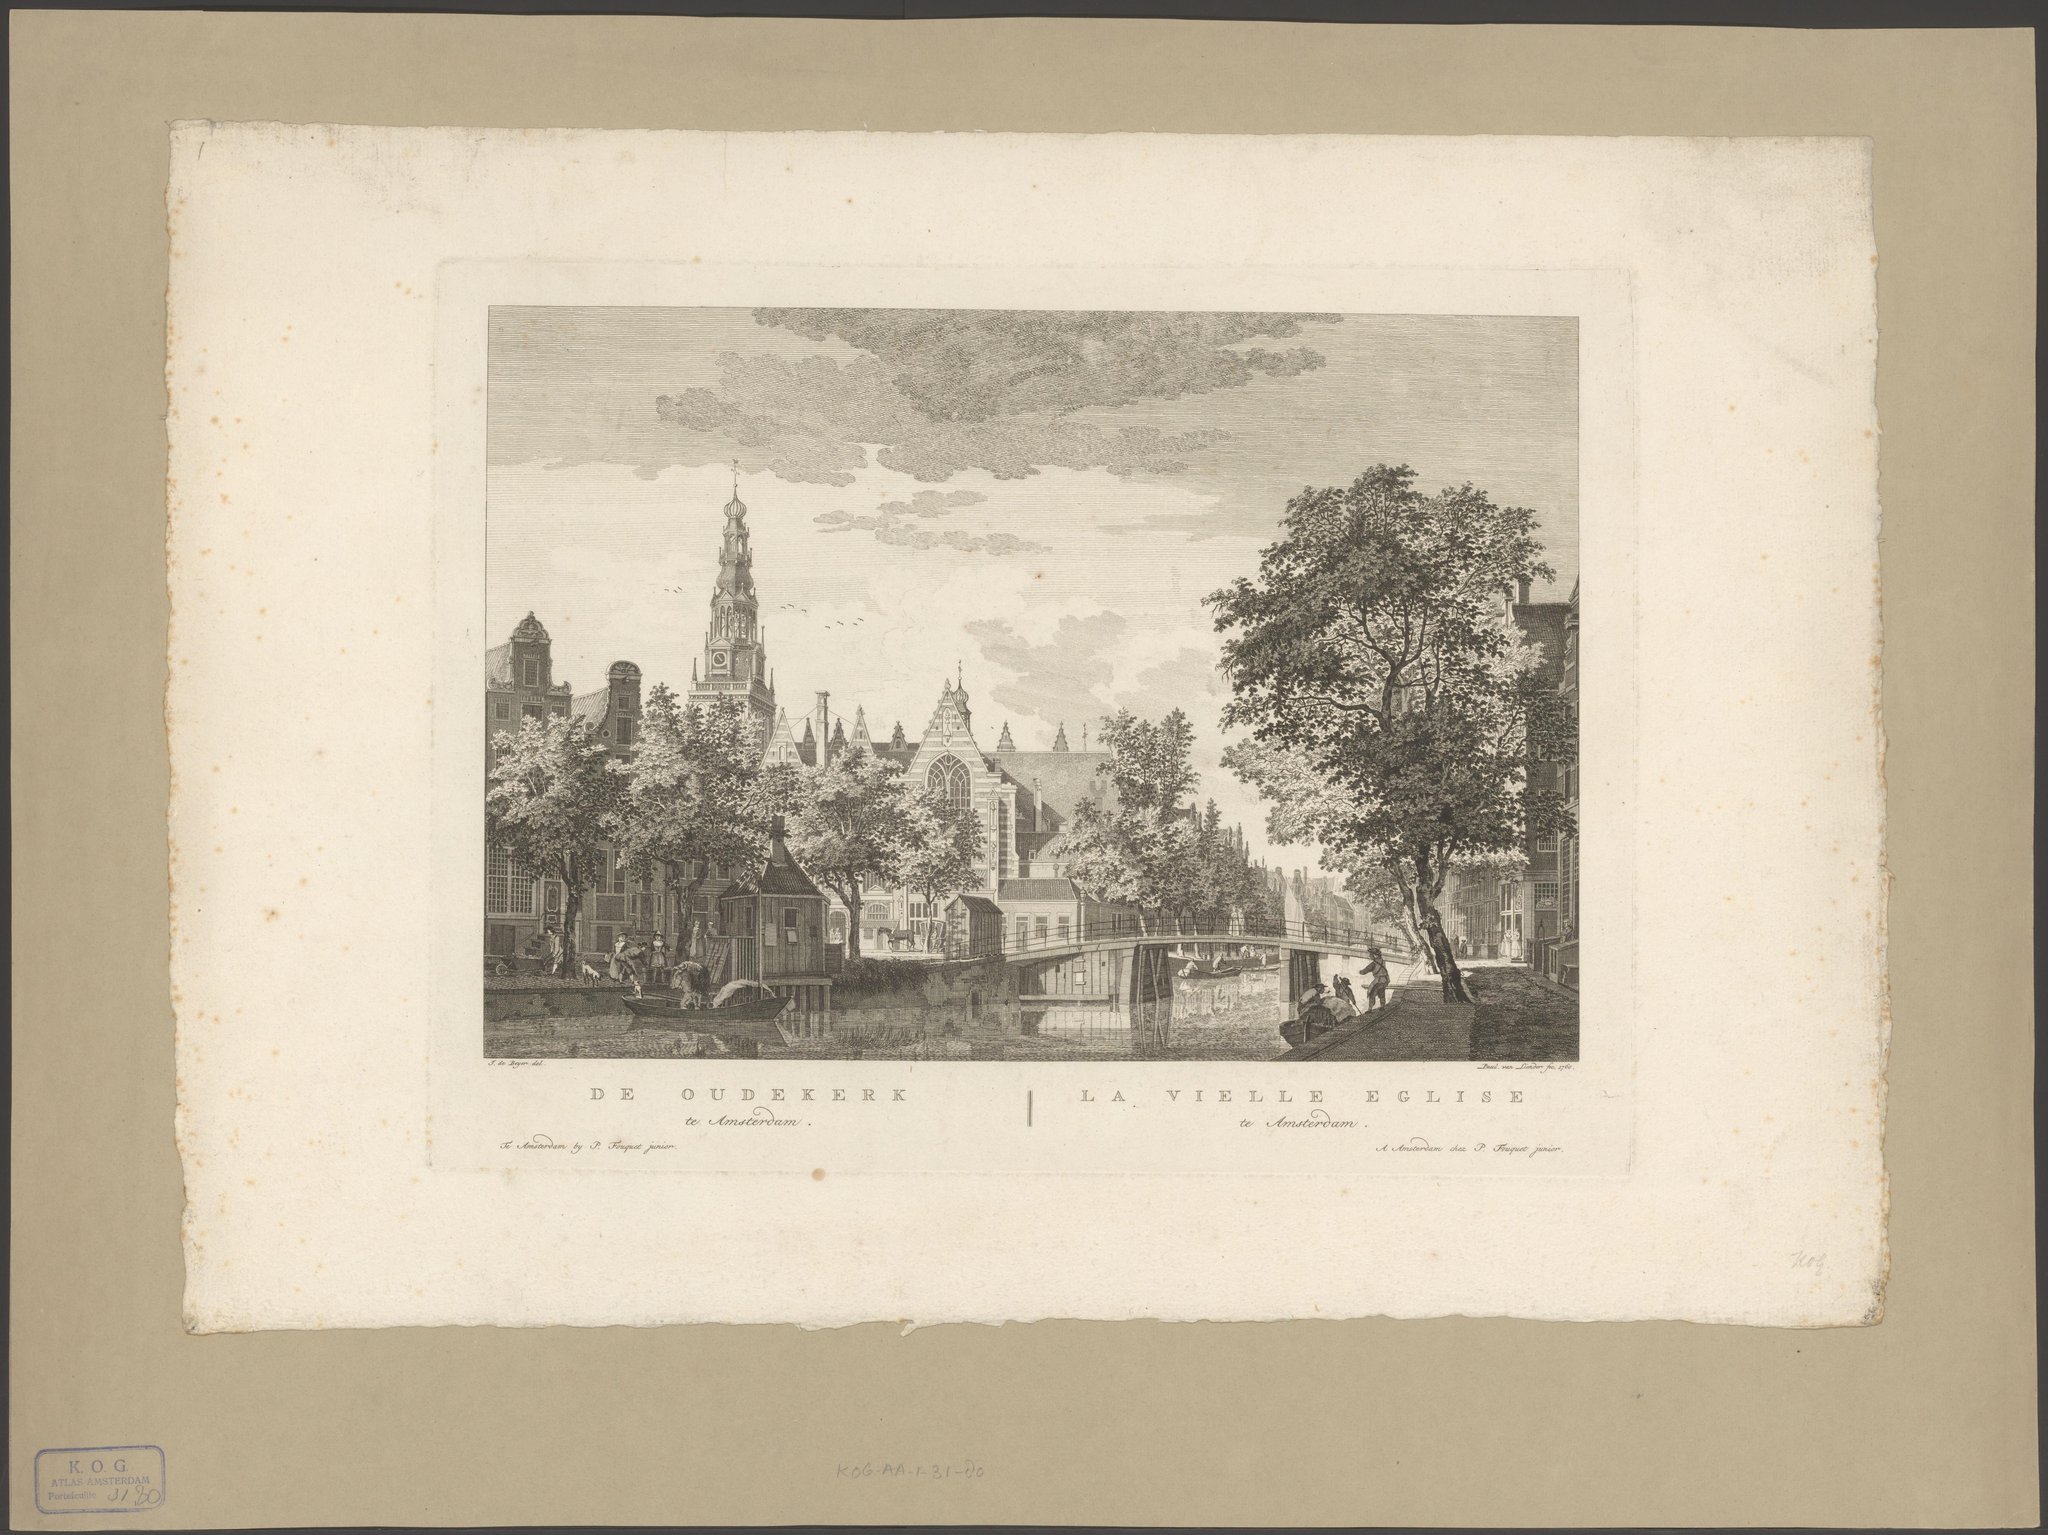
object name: print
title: Gezicht op de Oude Kerk te Amsterdam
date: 1760-1783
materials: paper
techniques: engraving, etching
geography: northern netherlands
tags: bridge in city across river, canal, etc. (+ city(-scape) with figures, staffage), church (exterior)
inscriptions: collector's mark: ‘31.80’ Lugt 1641b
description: Deze prent is ook gebruikt in de zogenaamde Atlas van Fouquet.* Pierre Fouquet gaf vanaf 1760 stadsgezichten van Amsterdam - naar tekeningen van verschillende kunstenaars, gemaakt door verschillende prentmakers - uit. Deze prenten werden aanvankelijk los of in series verkocht. Zoals toen gebruikelijk kon de koper de prenten zelf laten inbinden. Hiertoe gaf Fouquet tussen 1778 en 1783 een titelblad, plattegrond en inhoudsopgave van de tot dusver 100 uitgegeven prenten uit (1). Gezien de inhoud afhankelijk was van wat de koper had verzameld verschilt de inhoud van de verschillende bewaarde Fouquetatlassen onder deze titel sterk. Ook zijn er exemplaren bekend waar tevens andere prenten aan zijn toegevoegd. Omdat er behoefte bleek aan uitleg bij de platen werd in 1783 een nieuwe versie van de atlas uitgegeven, aangevuld met tekst en twee prenten. De aangegeven volgorde veranderde maar de platen van de al eerder uitgegeven prenten bleven ongewijzigd. Deze uitgave werd in opdracht van Fouquet gedrukt bij Daniël Jean Changuion en Petrus den Hengst (2). Een tiental platen werd bijgewerkt en verscheen, met nieuw impressum, in het vervolg van Wagenaars geschiedenis van Amsterdam, uitgeven door Petrus Conradi en Folkert van der Plaats (3). Een aantal jaar na het overlijden van Fouquet kwam Evert Maaskamp met een nieuwe uitgave van de atlas, met verbeterde tekst en toevoeging van twee prenten. Op alle platen verwijderde hij het oude en liet hij zijn eigen impressum zetten (4). De huidige staat van de prent komt voor in exemplaren van de onder (1) en (2) genoemde werken. * Onder de Atlas van Fouquet of Fouquetatlas verstaan we de hieronder vermelde publicaties (1), (2) en (4). (1). Afbeeldingen van de wyd-vermaarde koopstad Amsterdam benevens des zelvs voornaamste gebouwen en gezigten alle naar het leeven getekend / Receuil des edifices les plus considerables et des plus belles vues, de la fameuse ville d'Amsterdam, dessinées d'après nature. Amsterdam: Pierre Fouquet, 1778-1783. (2). Nieuwe atlas, van de voornaamste gebouwen en gezigten der stad Amsterdam, met derzelver beknopte beschryvingen. 2 dln. Amsterdam: Daniël Jean Changuion en Petrus den Hengst [in opdracht van Pierre Fouquet], 1783. (3). Stijl, Simon. Amsterdam, in zyne geschiedenissen, voorregten, koophandel, gebouwen, kerkenstaat, schoolen, schutterye, gilden en regeeringe, beschreeven. Om te dienen ten vervolge op het werk van Jan Wagenaar (…). 10 dln. Amsterdam en Harlingen: Petrus Conradi en Folkert van der Plaats, 1788-1801. (4). Nieuwe atlas, van de voornaamste gebouwen en gezigten der stad Amsterdam. Met derzelver beknopte beschryvingen. Amsterdam: Evert Maaskamp, 1805. * Het aantal vermelde staten is gebaseerd op het aantal gevonden staten. Mogelijk zijn er meer staten van deze prent. Voor eerste bekende staat zie RP-P-AO-23-5.